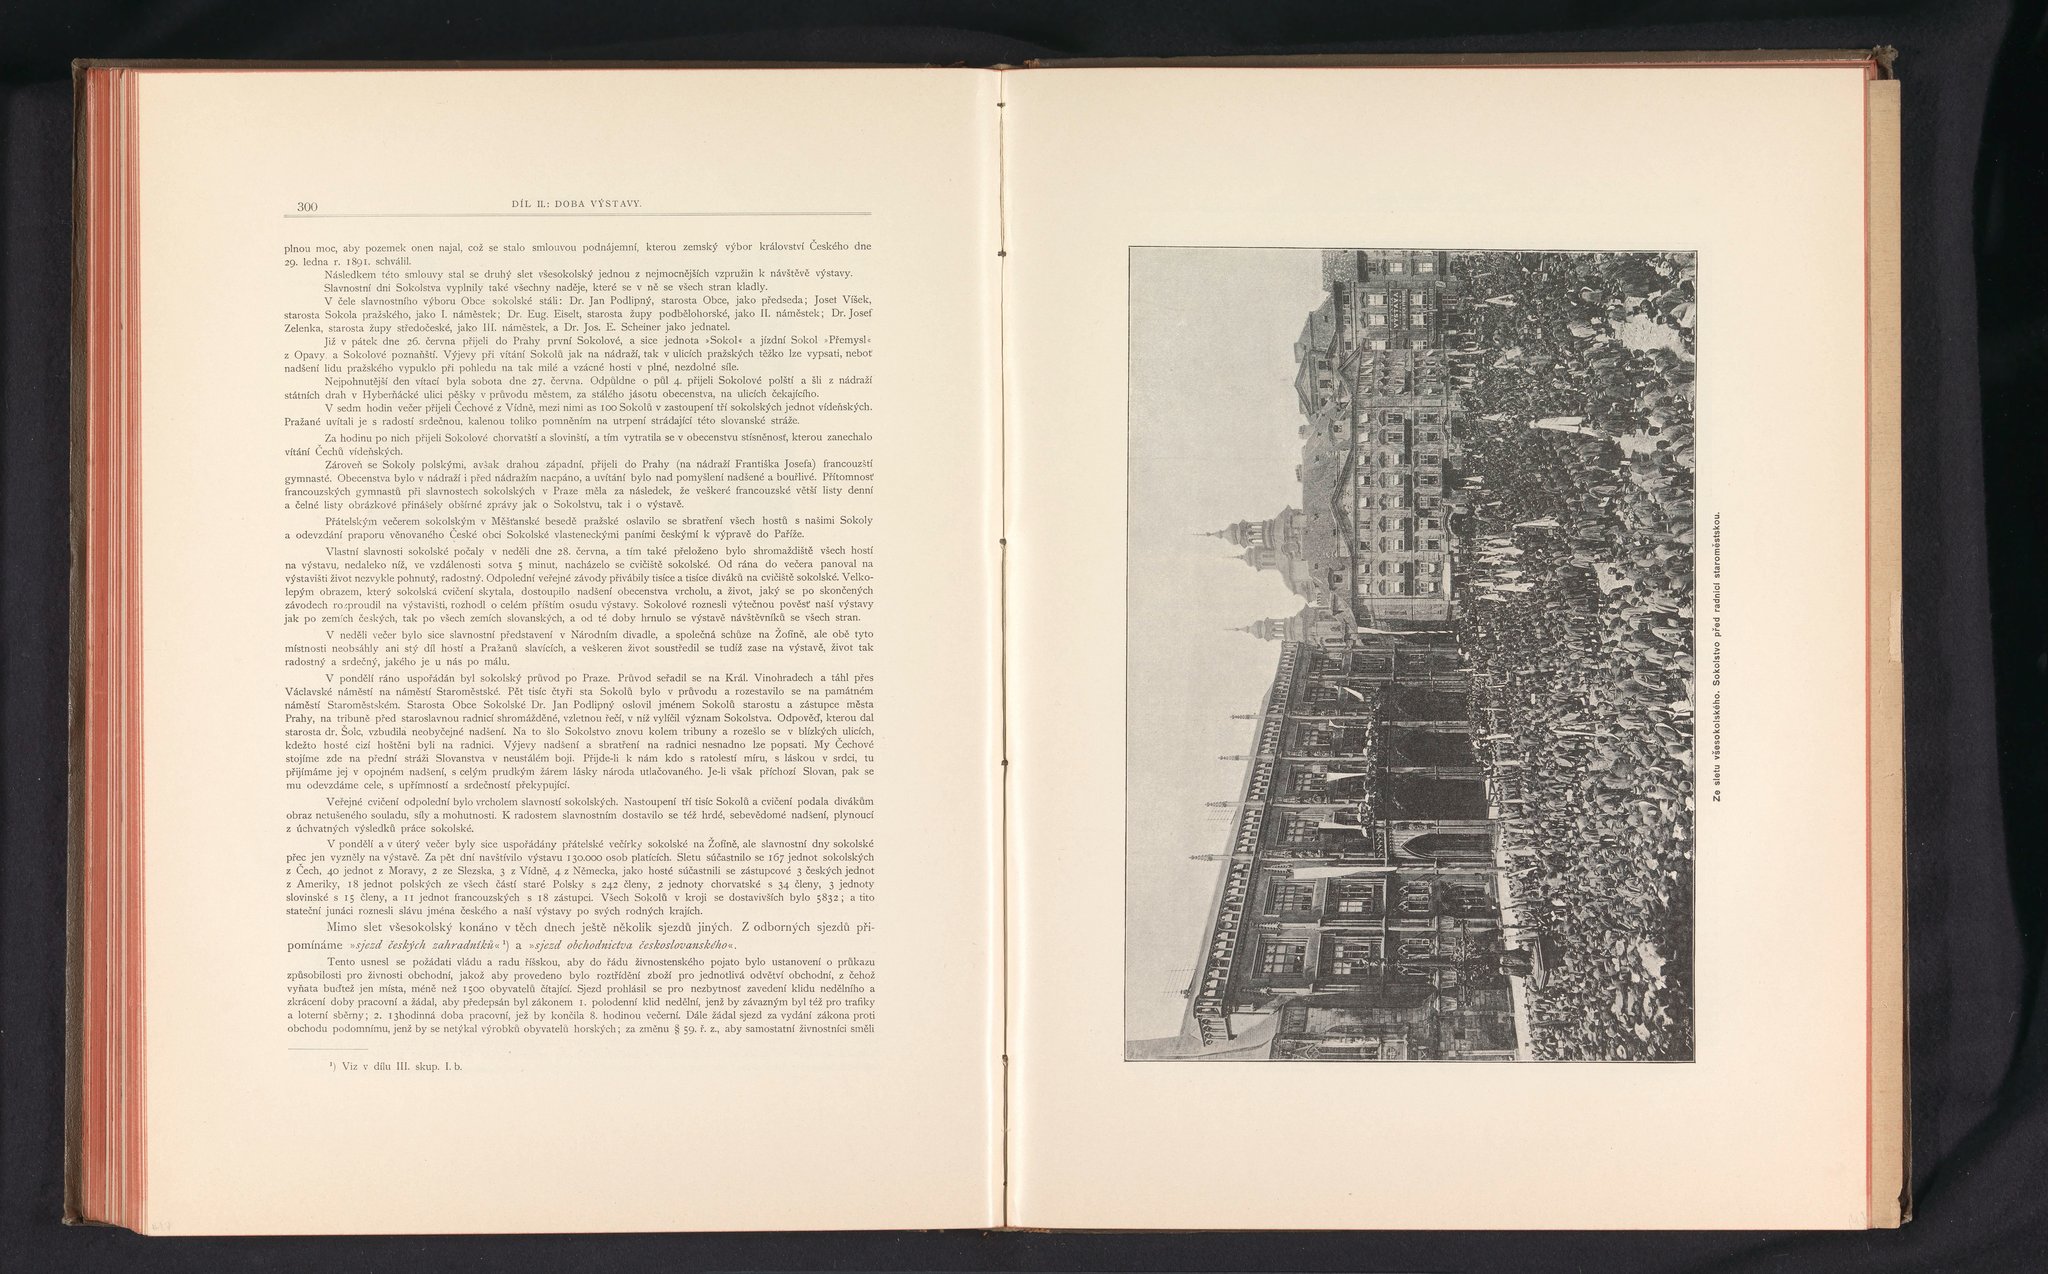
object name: page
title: Menigte op het Staroměstské náměstí te Praag tijdens een festival van de Sokol-beweging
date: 1891-1893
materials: paper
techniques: autotype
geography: prague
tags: public festivities, village square, place